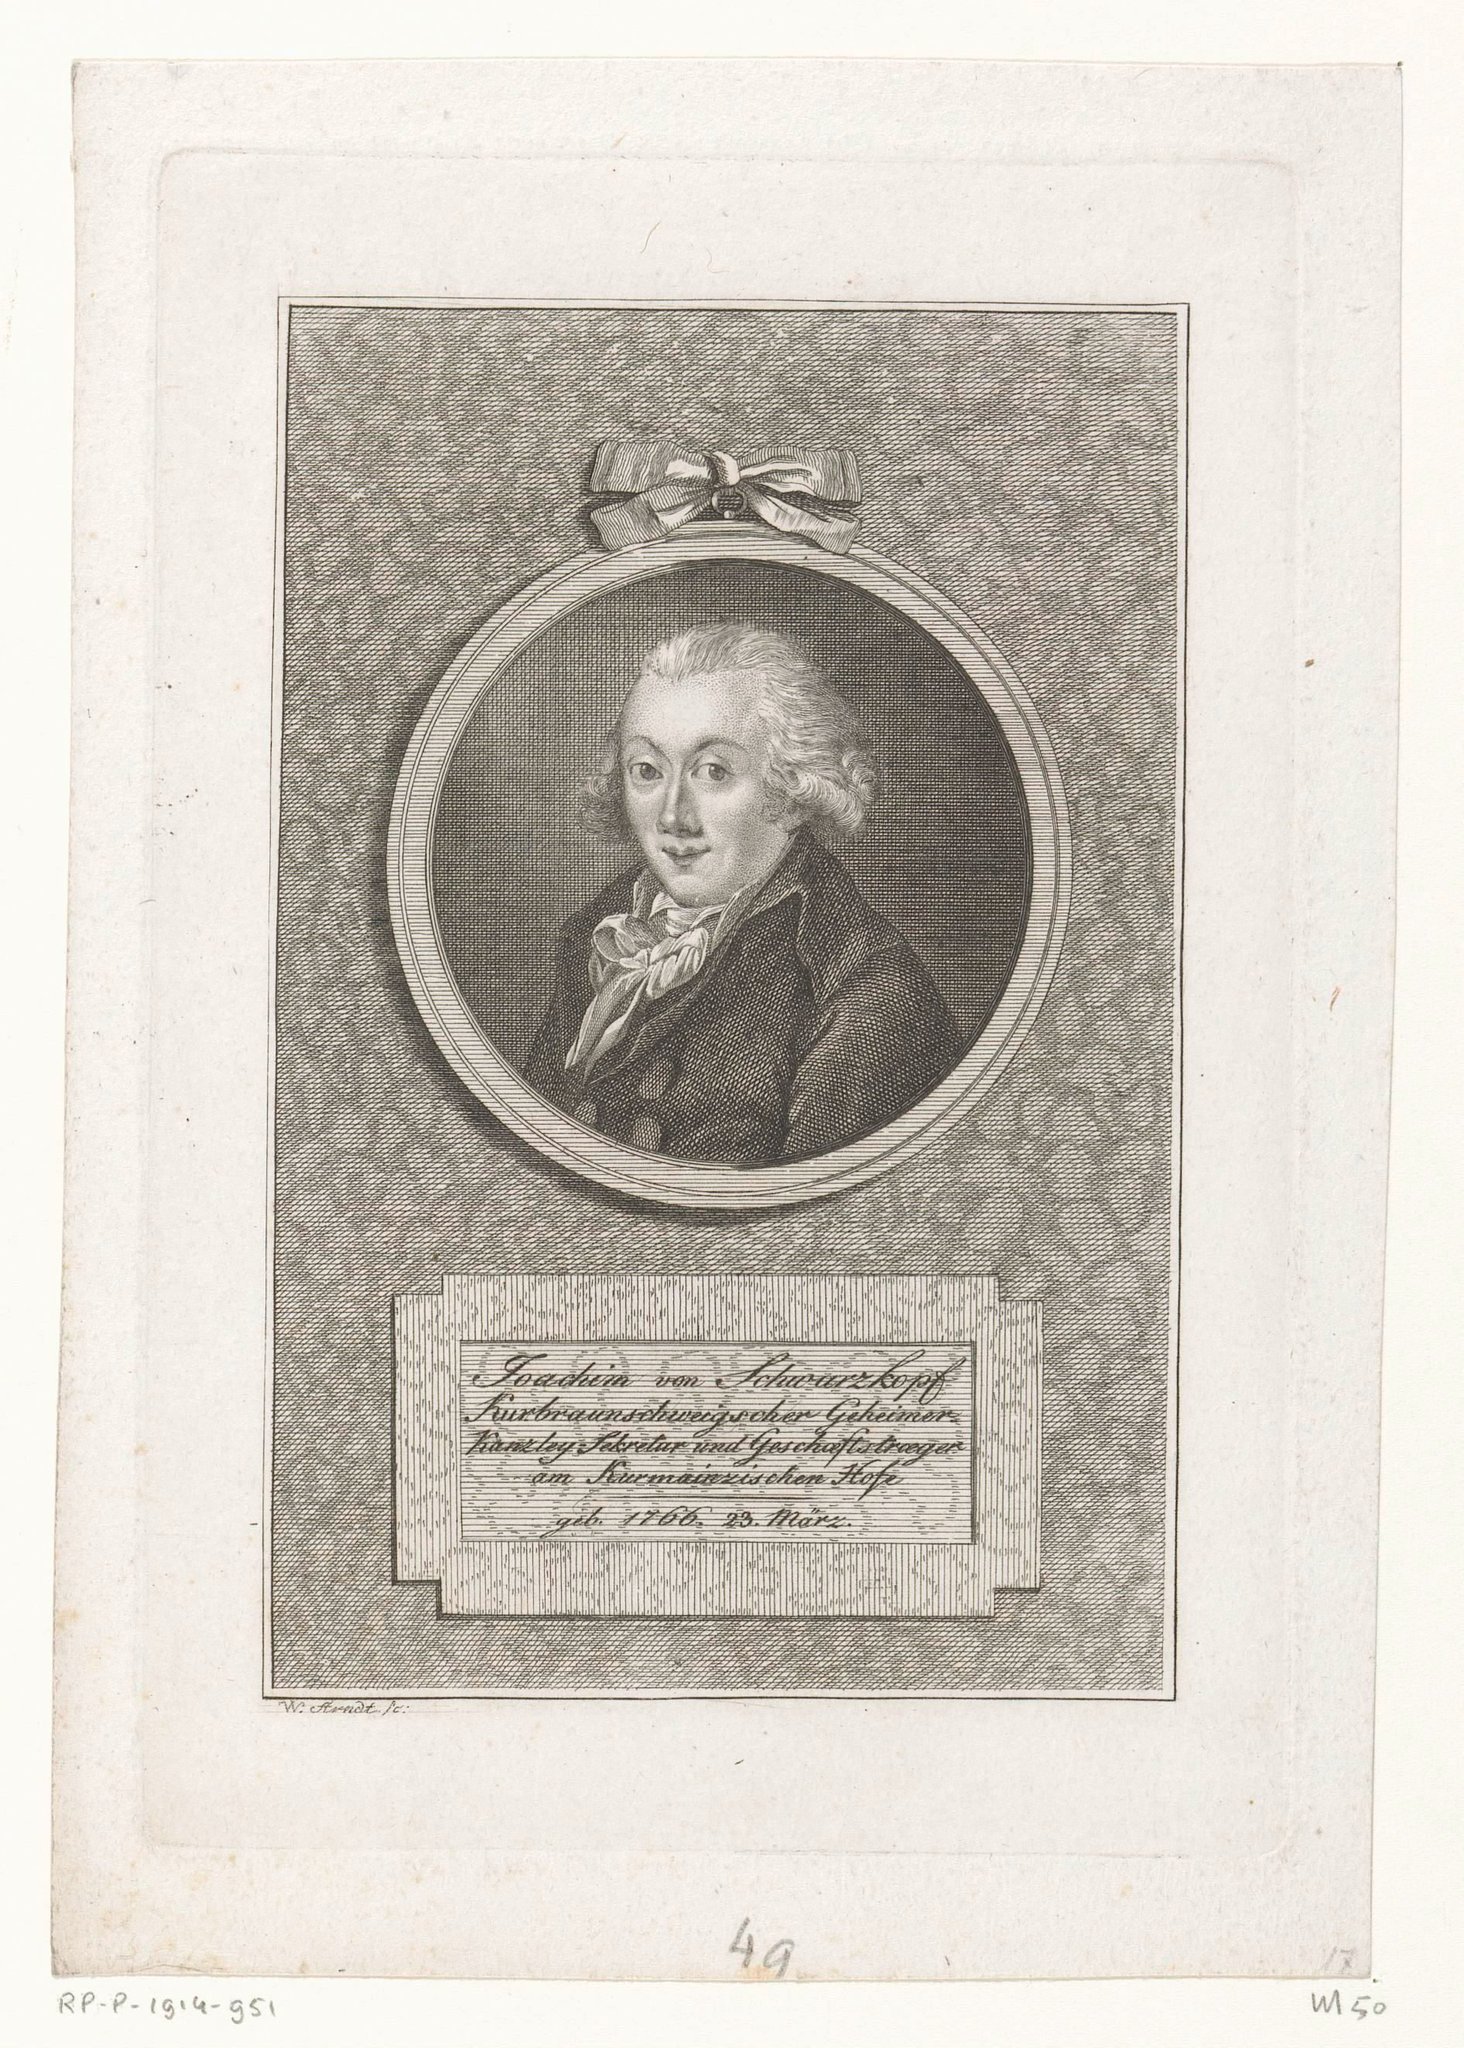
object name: print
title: Joachim von Schwarzkopf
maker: wilhelm arndt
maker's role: print maker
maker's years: 1750-1813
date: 1780-1813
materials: paper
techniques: etching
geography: germany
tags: historical persons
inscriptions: collector's mark: Lugt 2228